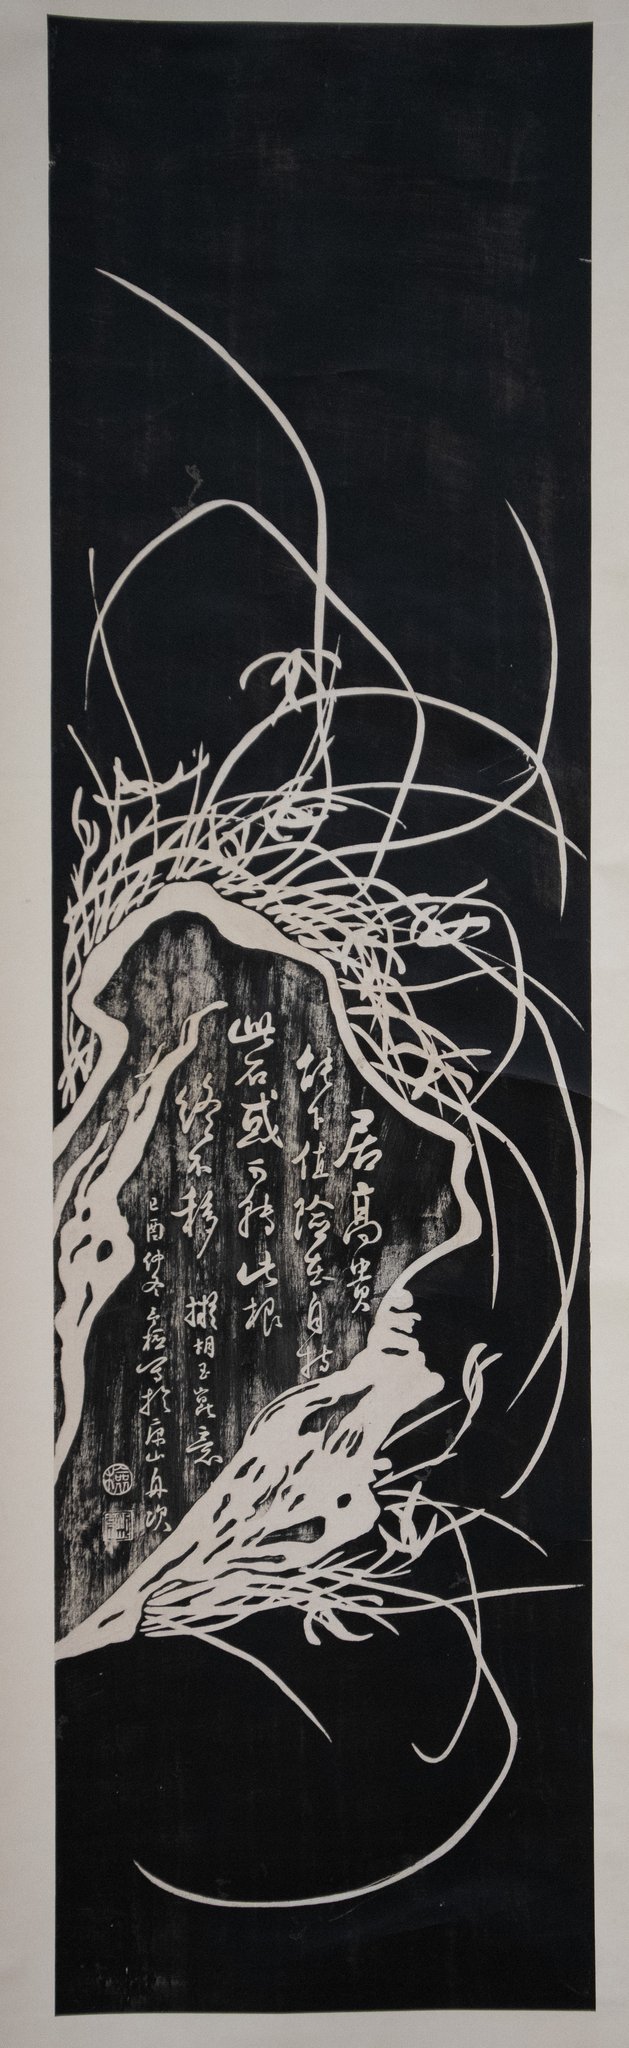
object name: print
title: Orchids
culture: chinese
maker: zhang yujian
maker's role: artist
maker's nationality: chinese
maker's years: 1736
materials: ink, paper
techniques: polychrome, woodblock print